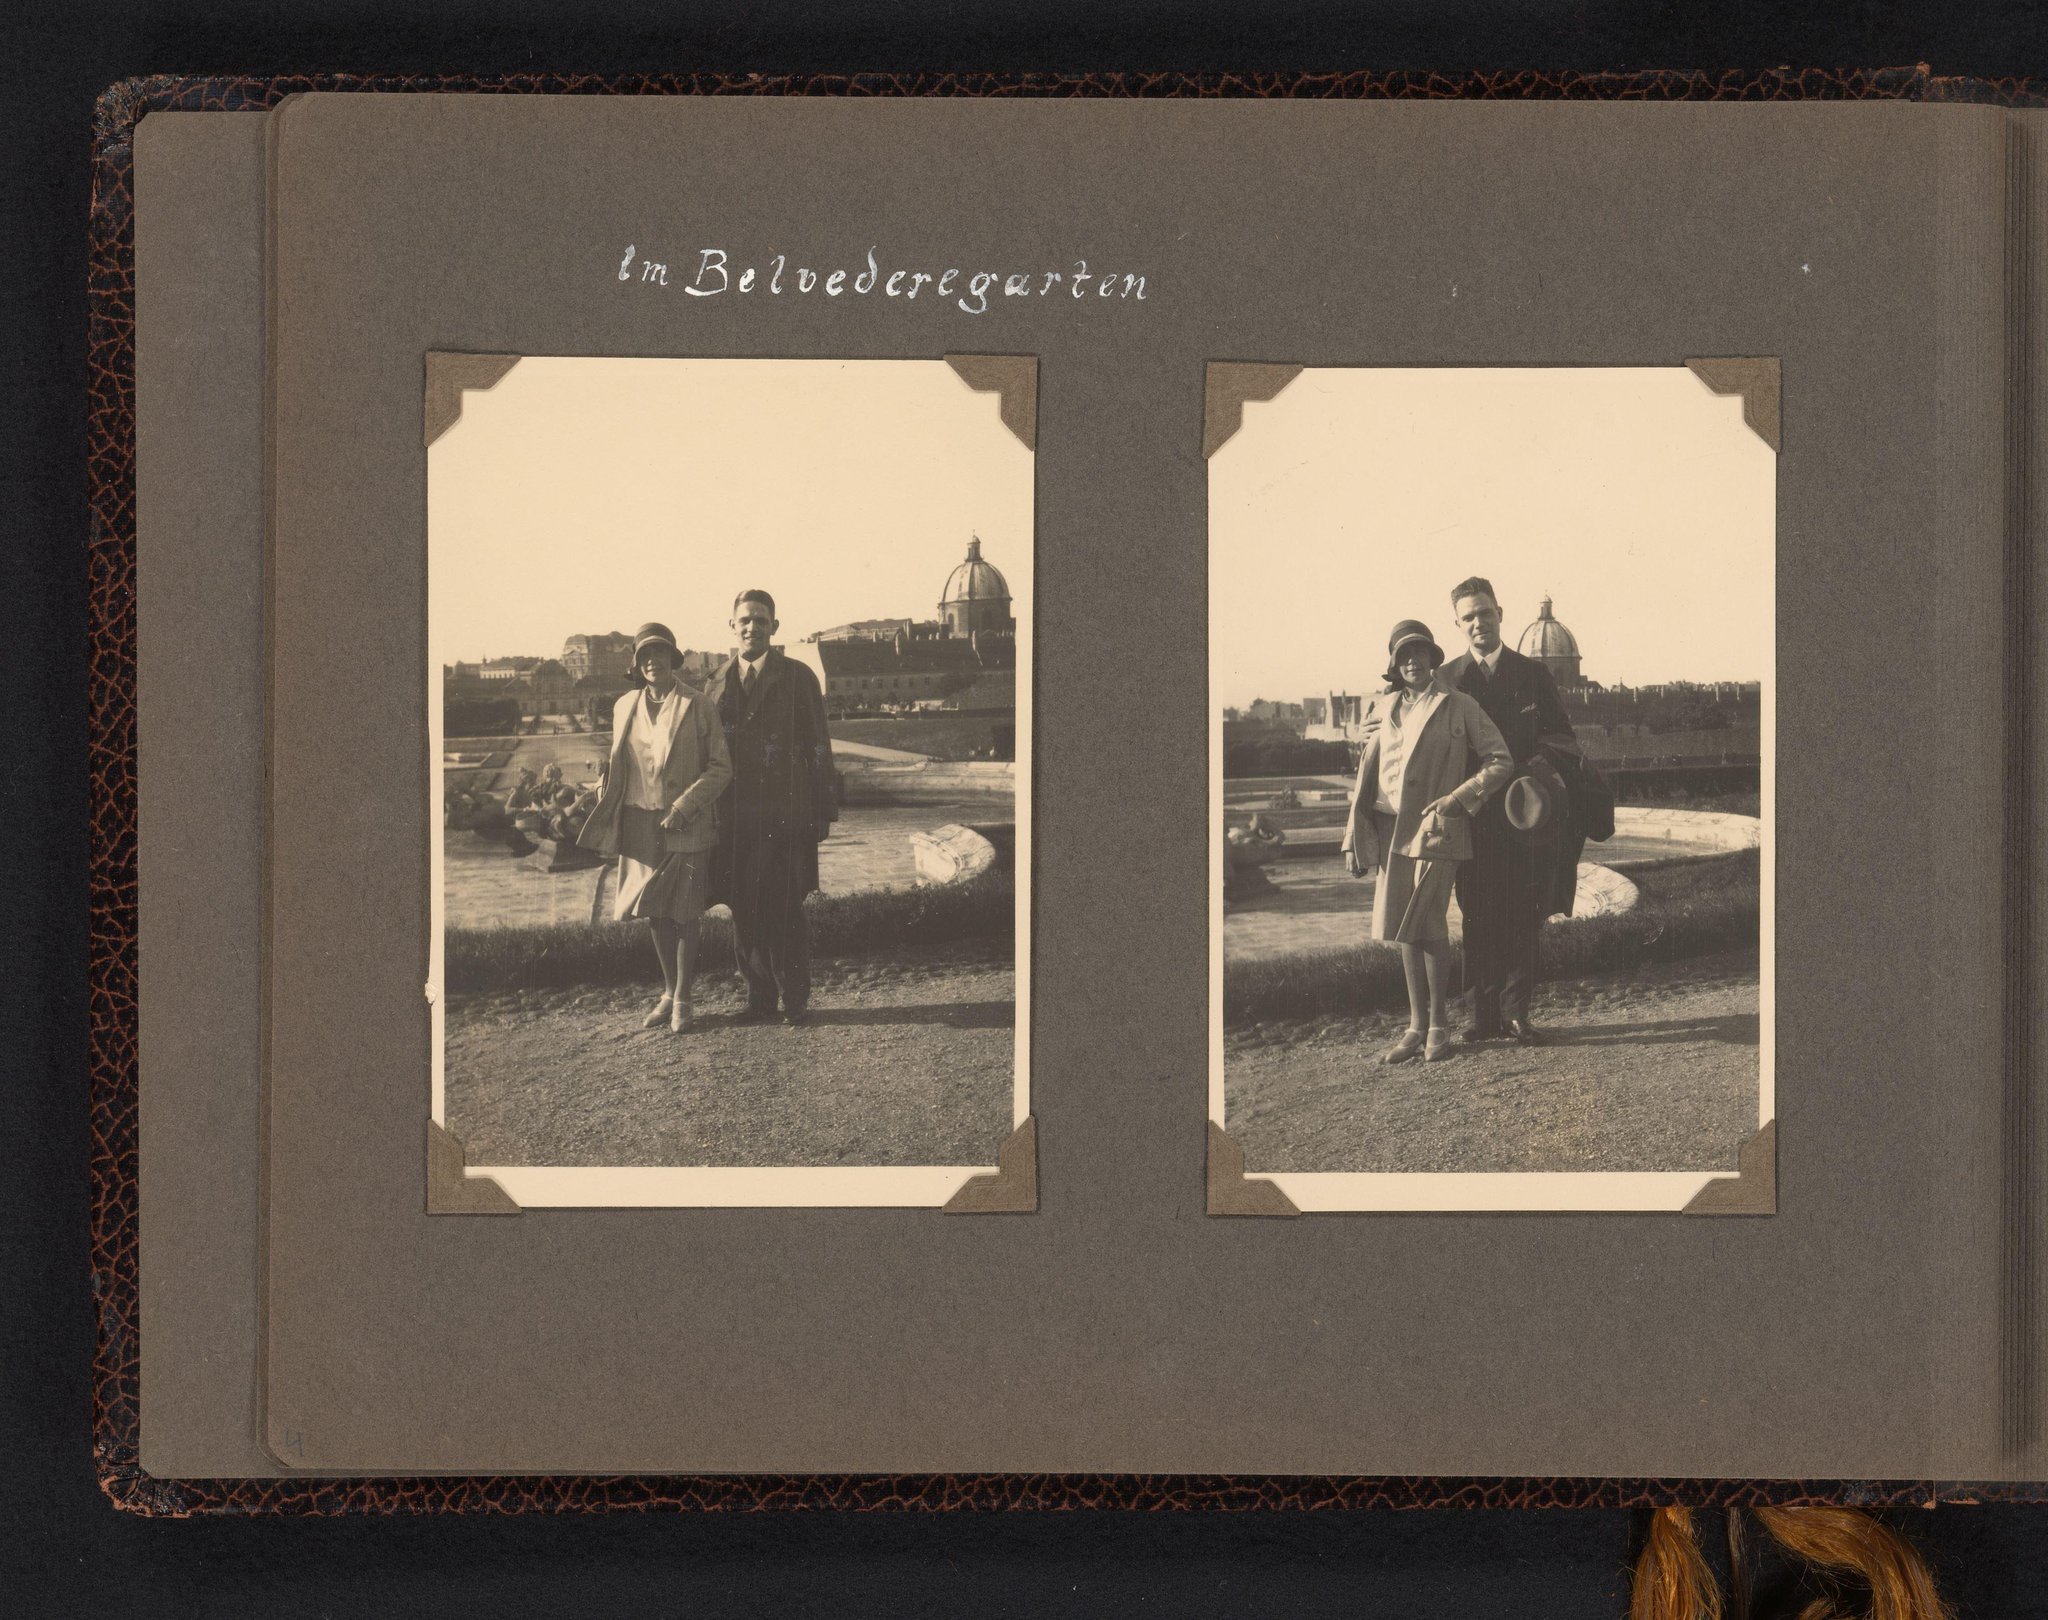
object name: album leaf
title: Echtpaar Berti Hoppe en Herman Besselaar bij het Slot Belvedere te Wenen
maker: Anonymous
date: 1930-1931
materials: cardboard, paper, photographic support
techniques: gelatin silver print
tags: herman besselaar, berti hoppe, historical persons - bb - woman, historical persons, french or architectonic garden; formal garden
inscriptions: annotation: ‘im Belvederegarten’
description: Twee foto's gemaakt tijdens hun verlovingsreis naar Wenen en Boedapest. Deze pagina maakt deel uit van een album.